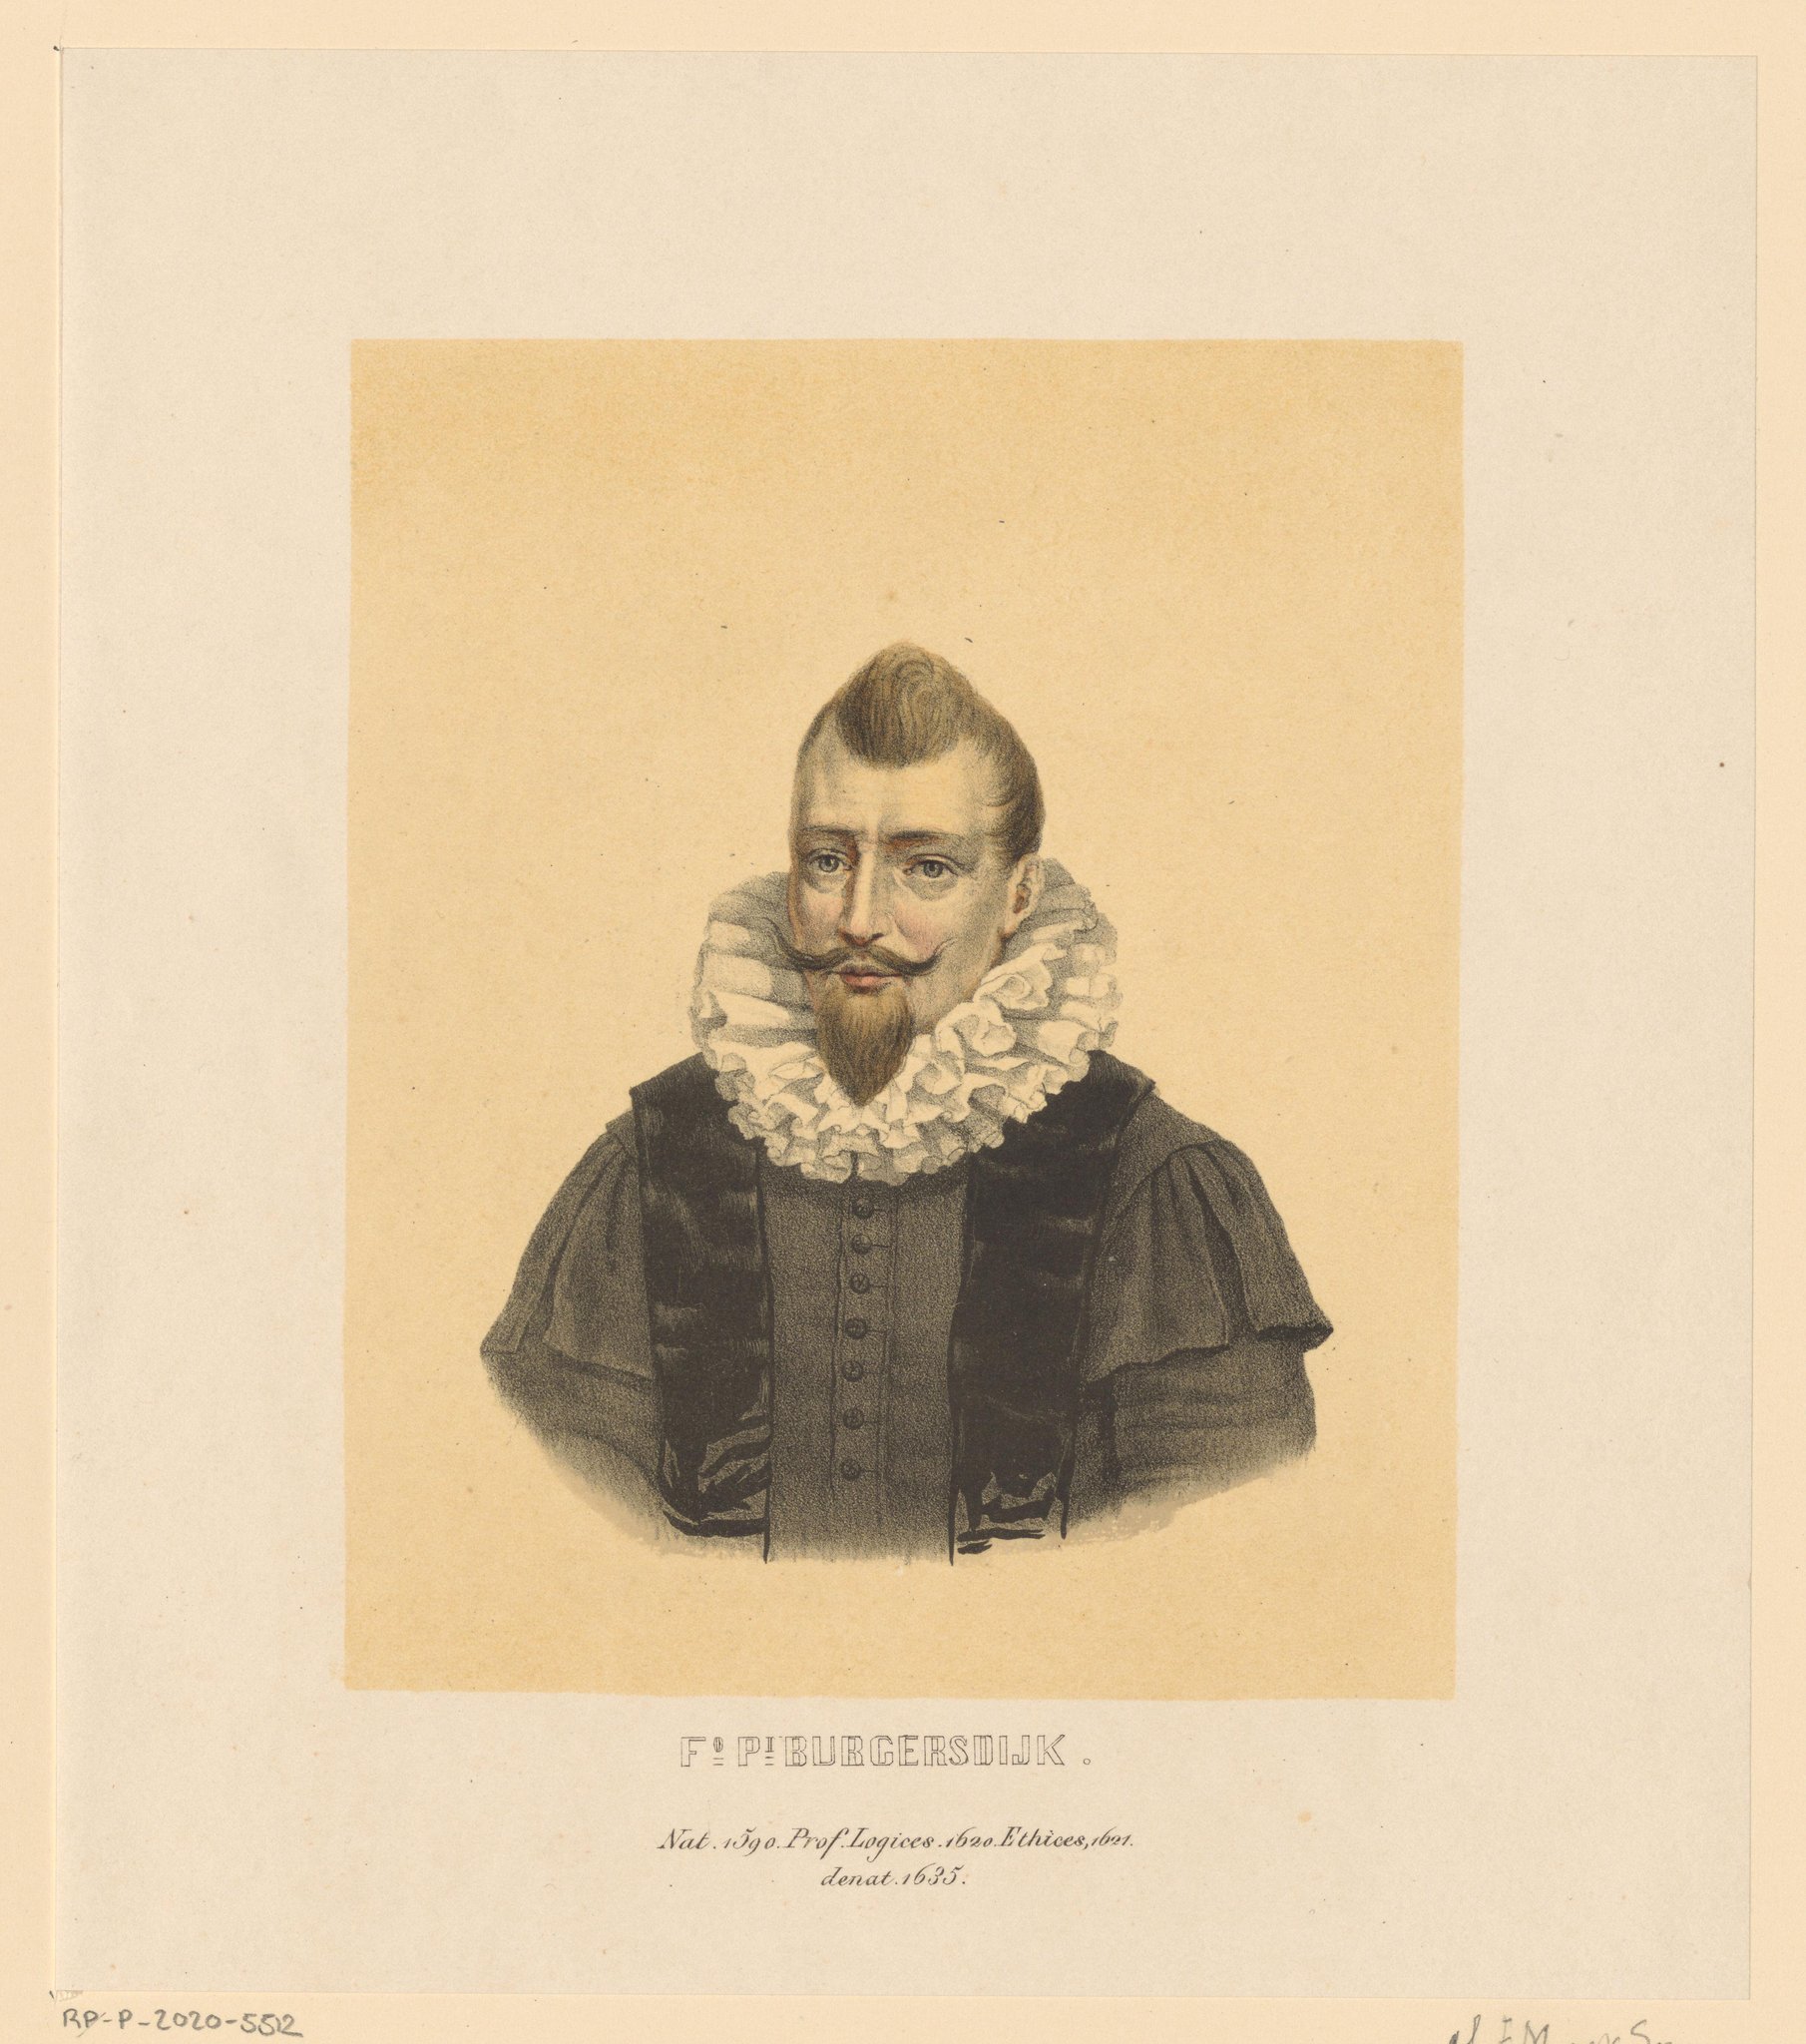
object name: print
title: Portret van Franco Petri Burgersdijck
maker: Anonymous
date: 1825-1874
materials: paper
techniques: hand coloring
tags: leiden, scholar, philosopher, historical persons